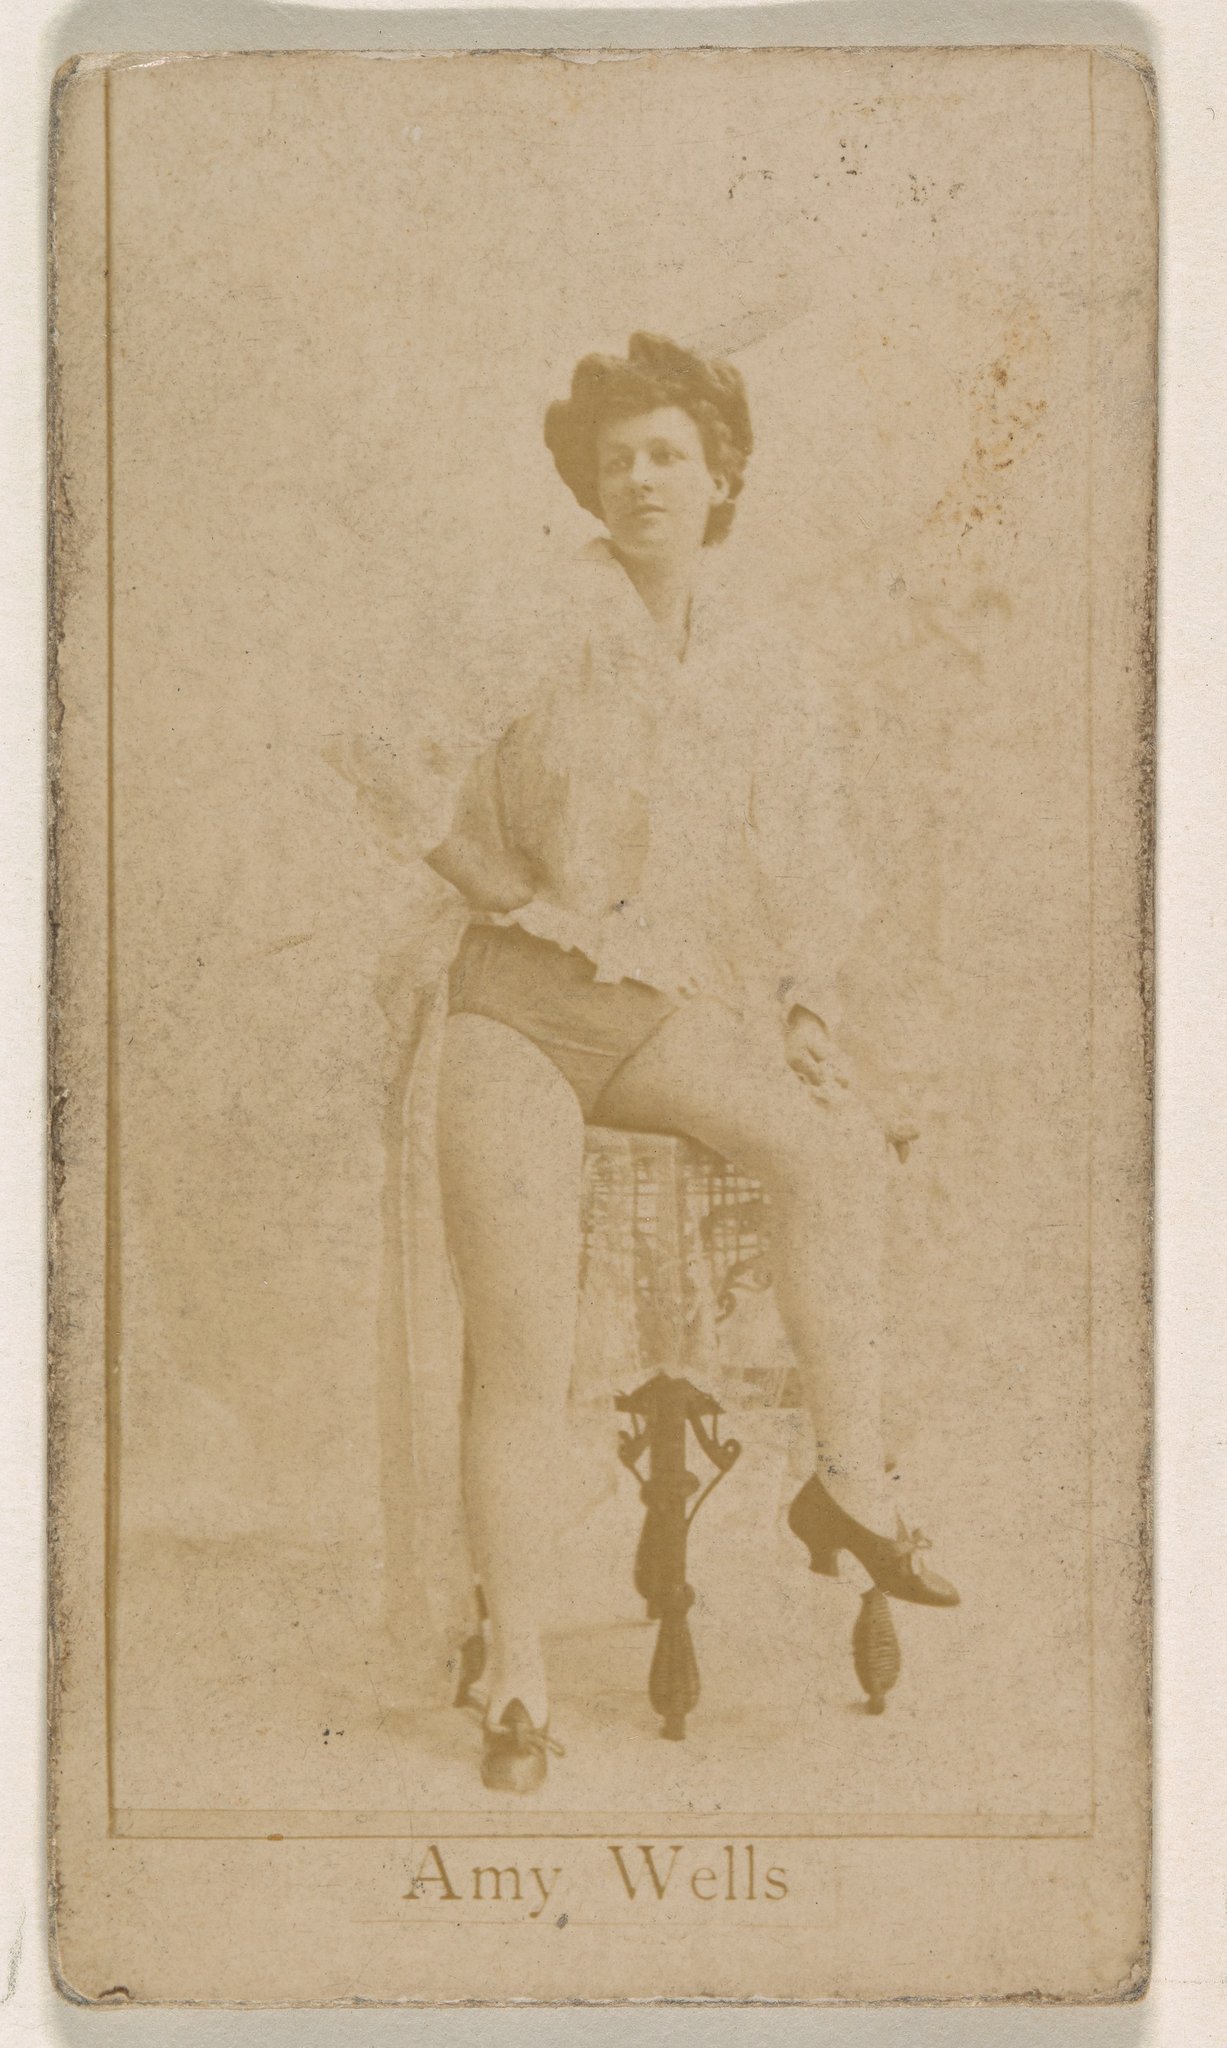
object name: photograph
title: Amy Wells, from the Actresses series (N245) issued by Kinney Brothers to promote Sweet Caporal Cigarettes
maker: kinney brothers tobacco company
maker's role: publisher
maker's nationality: american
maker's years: 1869-2011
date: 1890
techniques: albumen silver print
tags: portraits,women,actresses